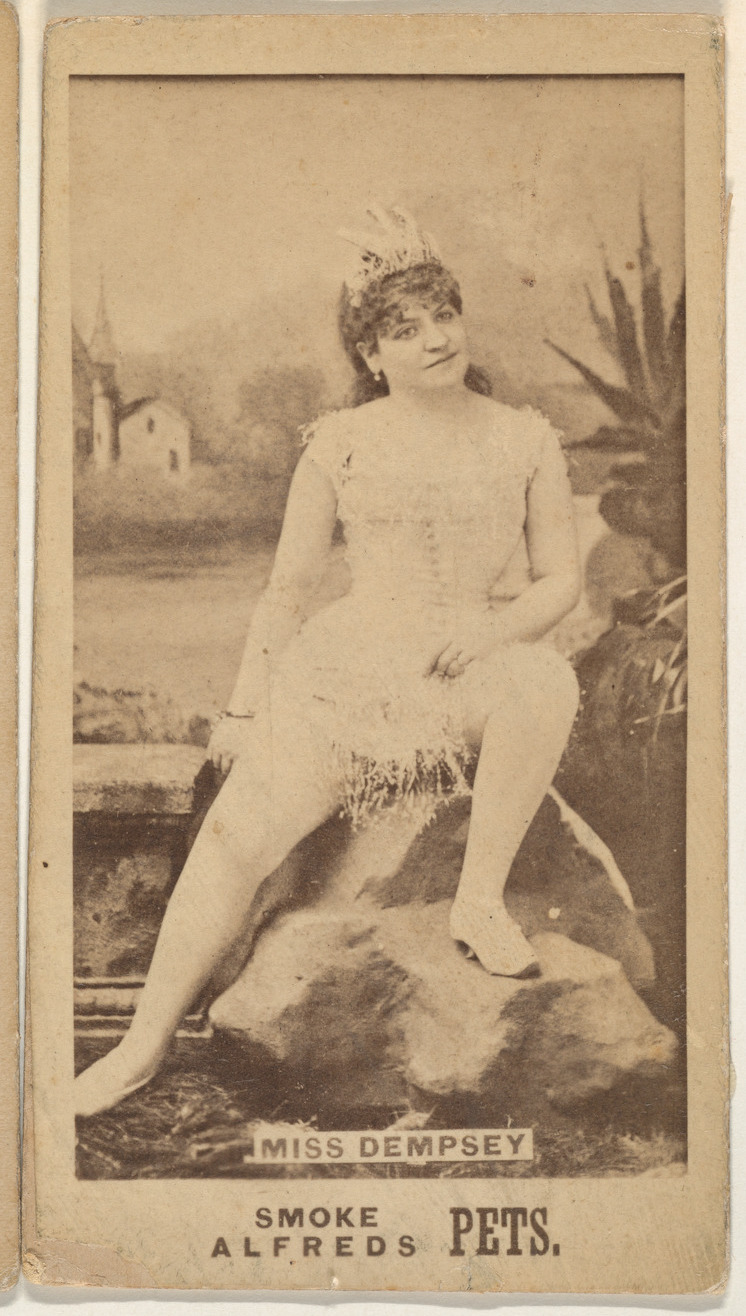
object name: photograph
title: Miss Dempsey, from the Actresses series (N671), promoting Alfreds Pets Tobacco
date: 1888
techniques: albumen silver print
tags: portraits,women,actresses